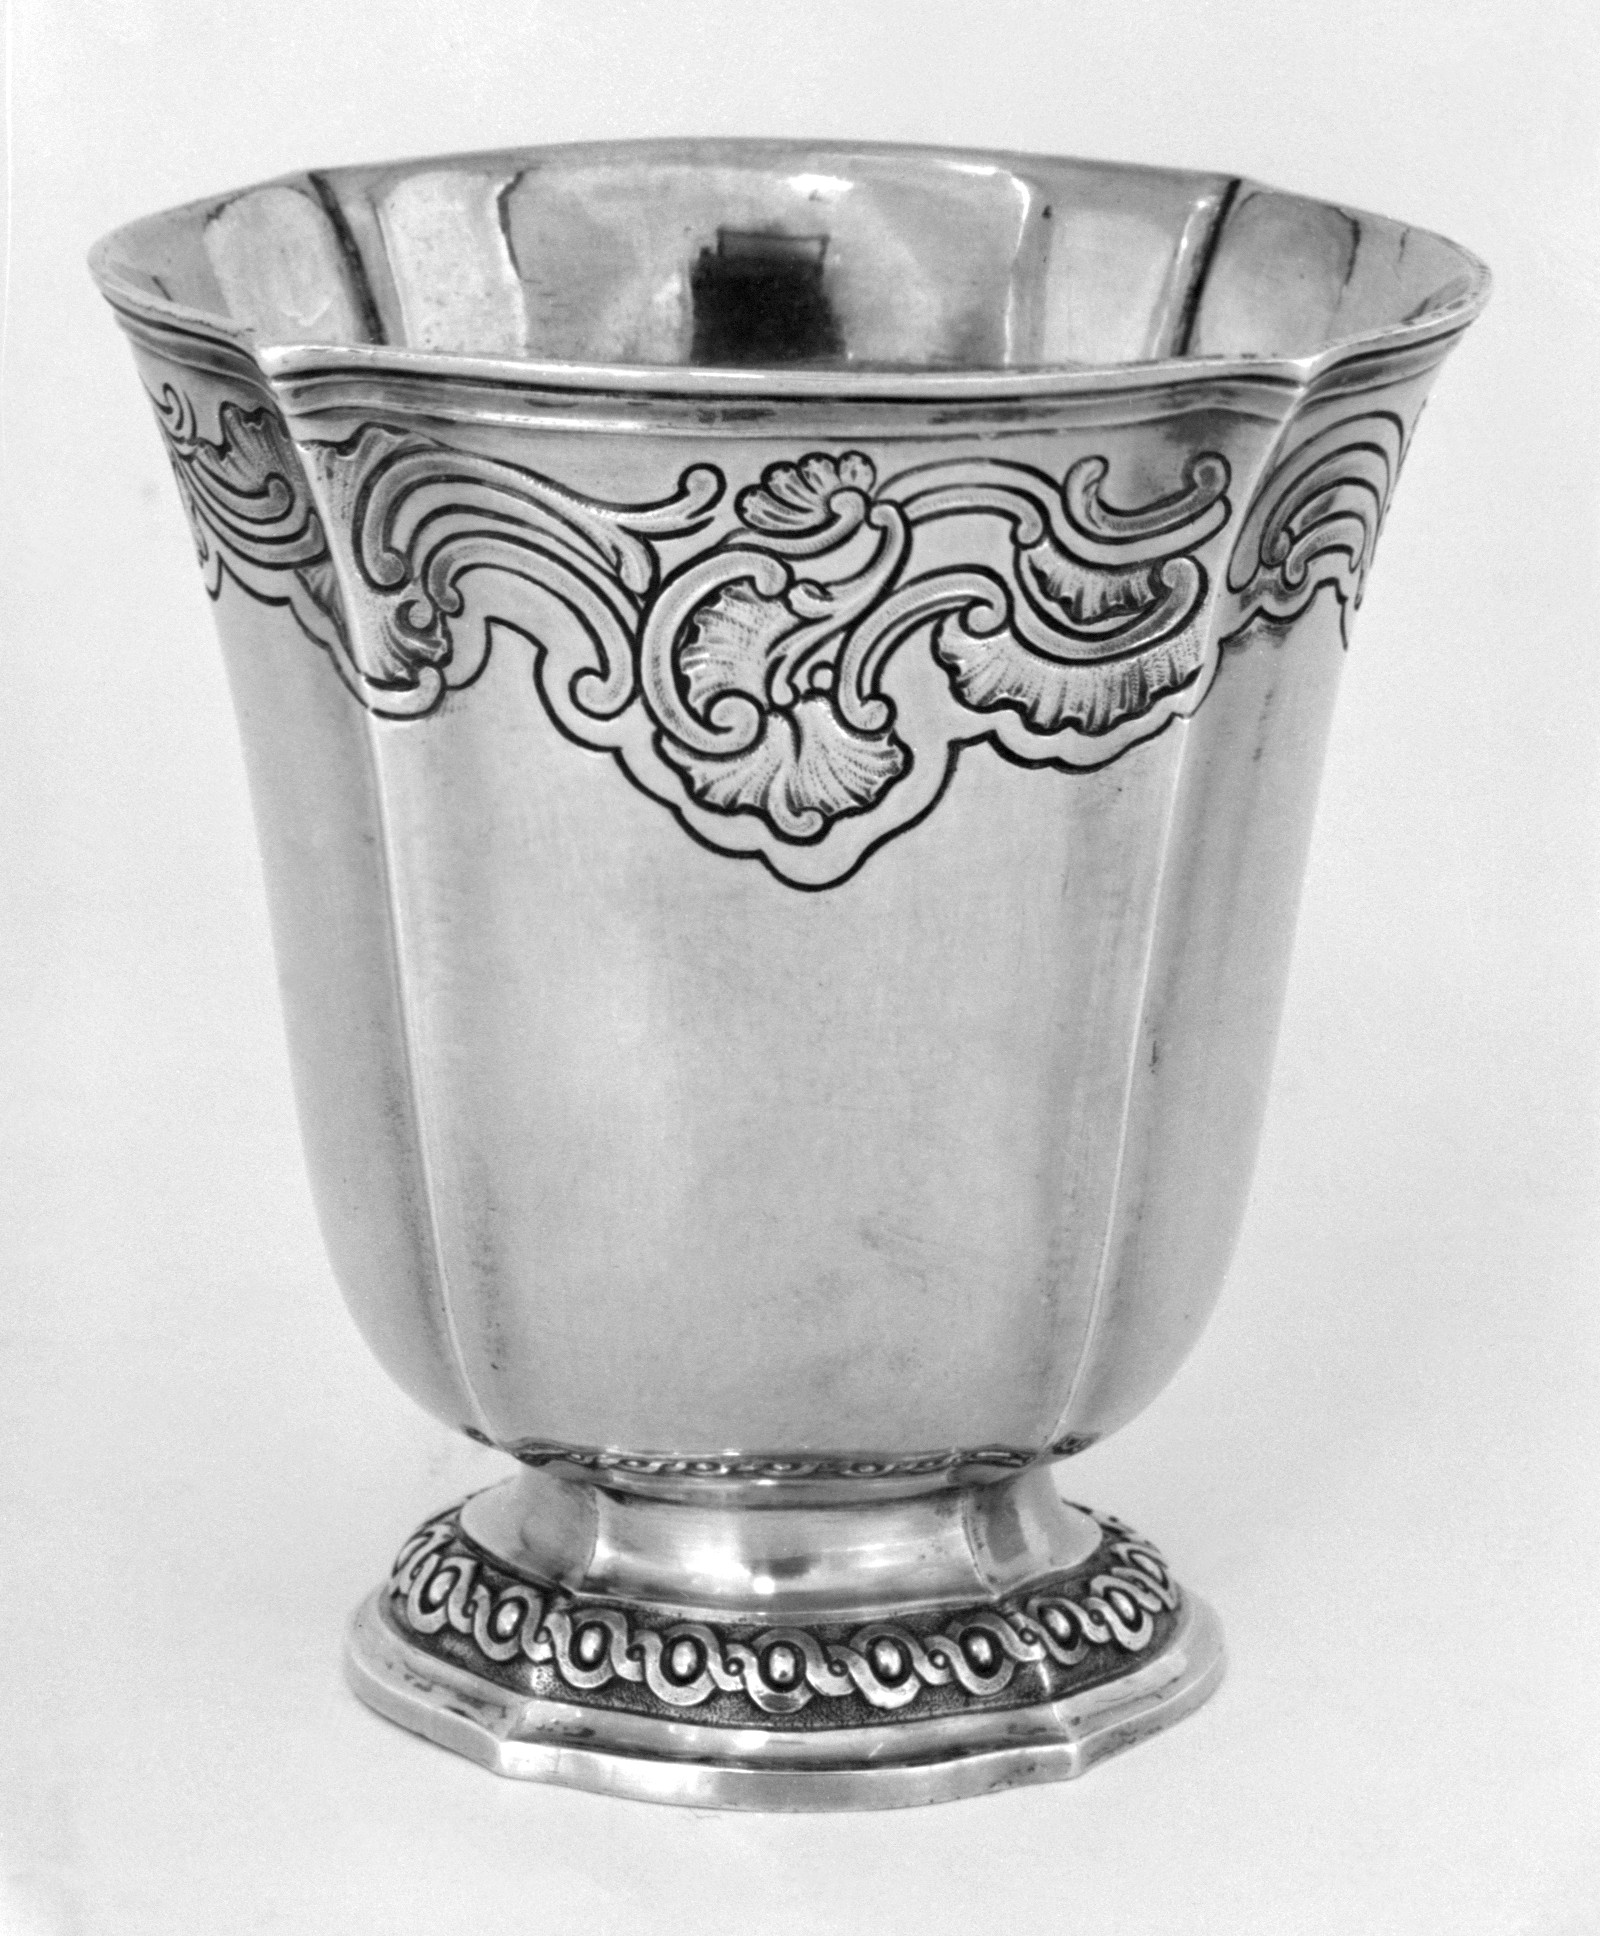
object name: beaker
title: Beaker (one of a pair)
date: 1701-1800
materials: silver gilt